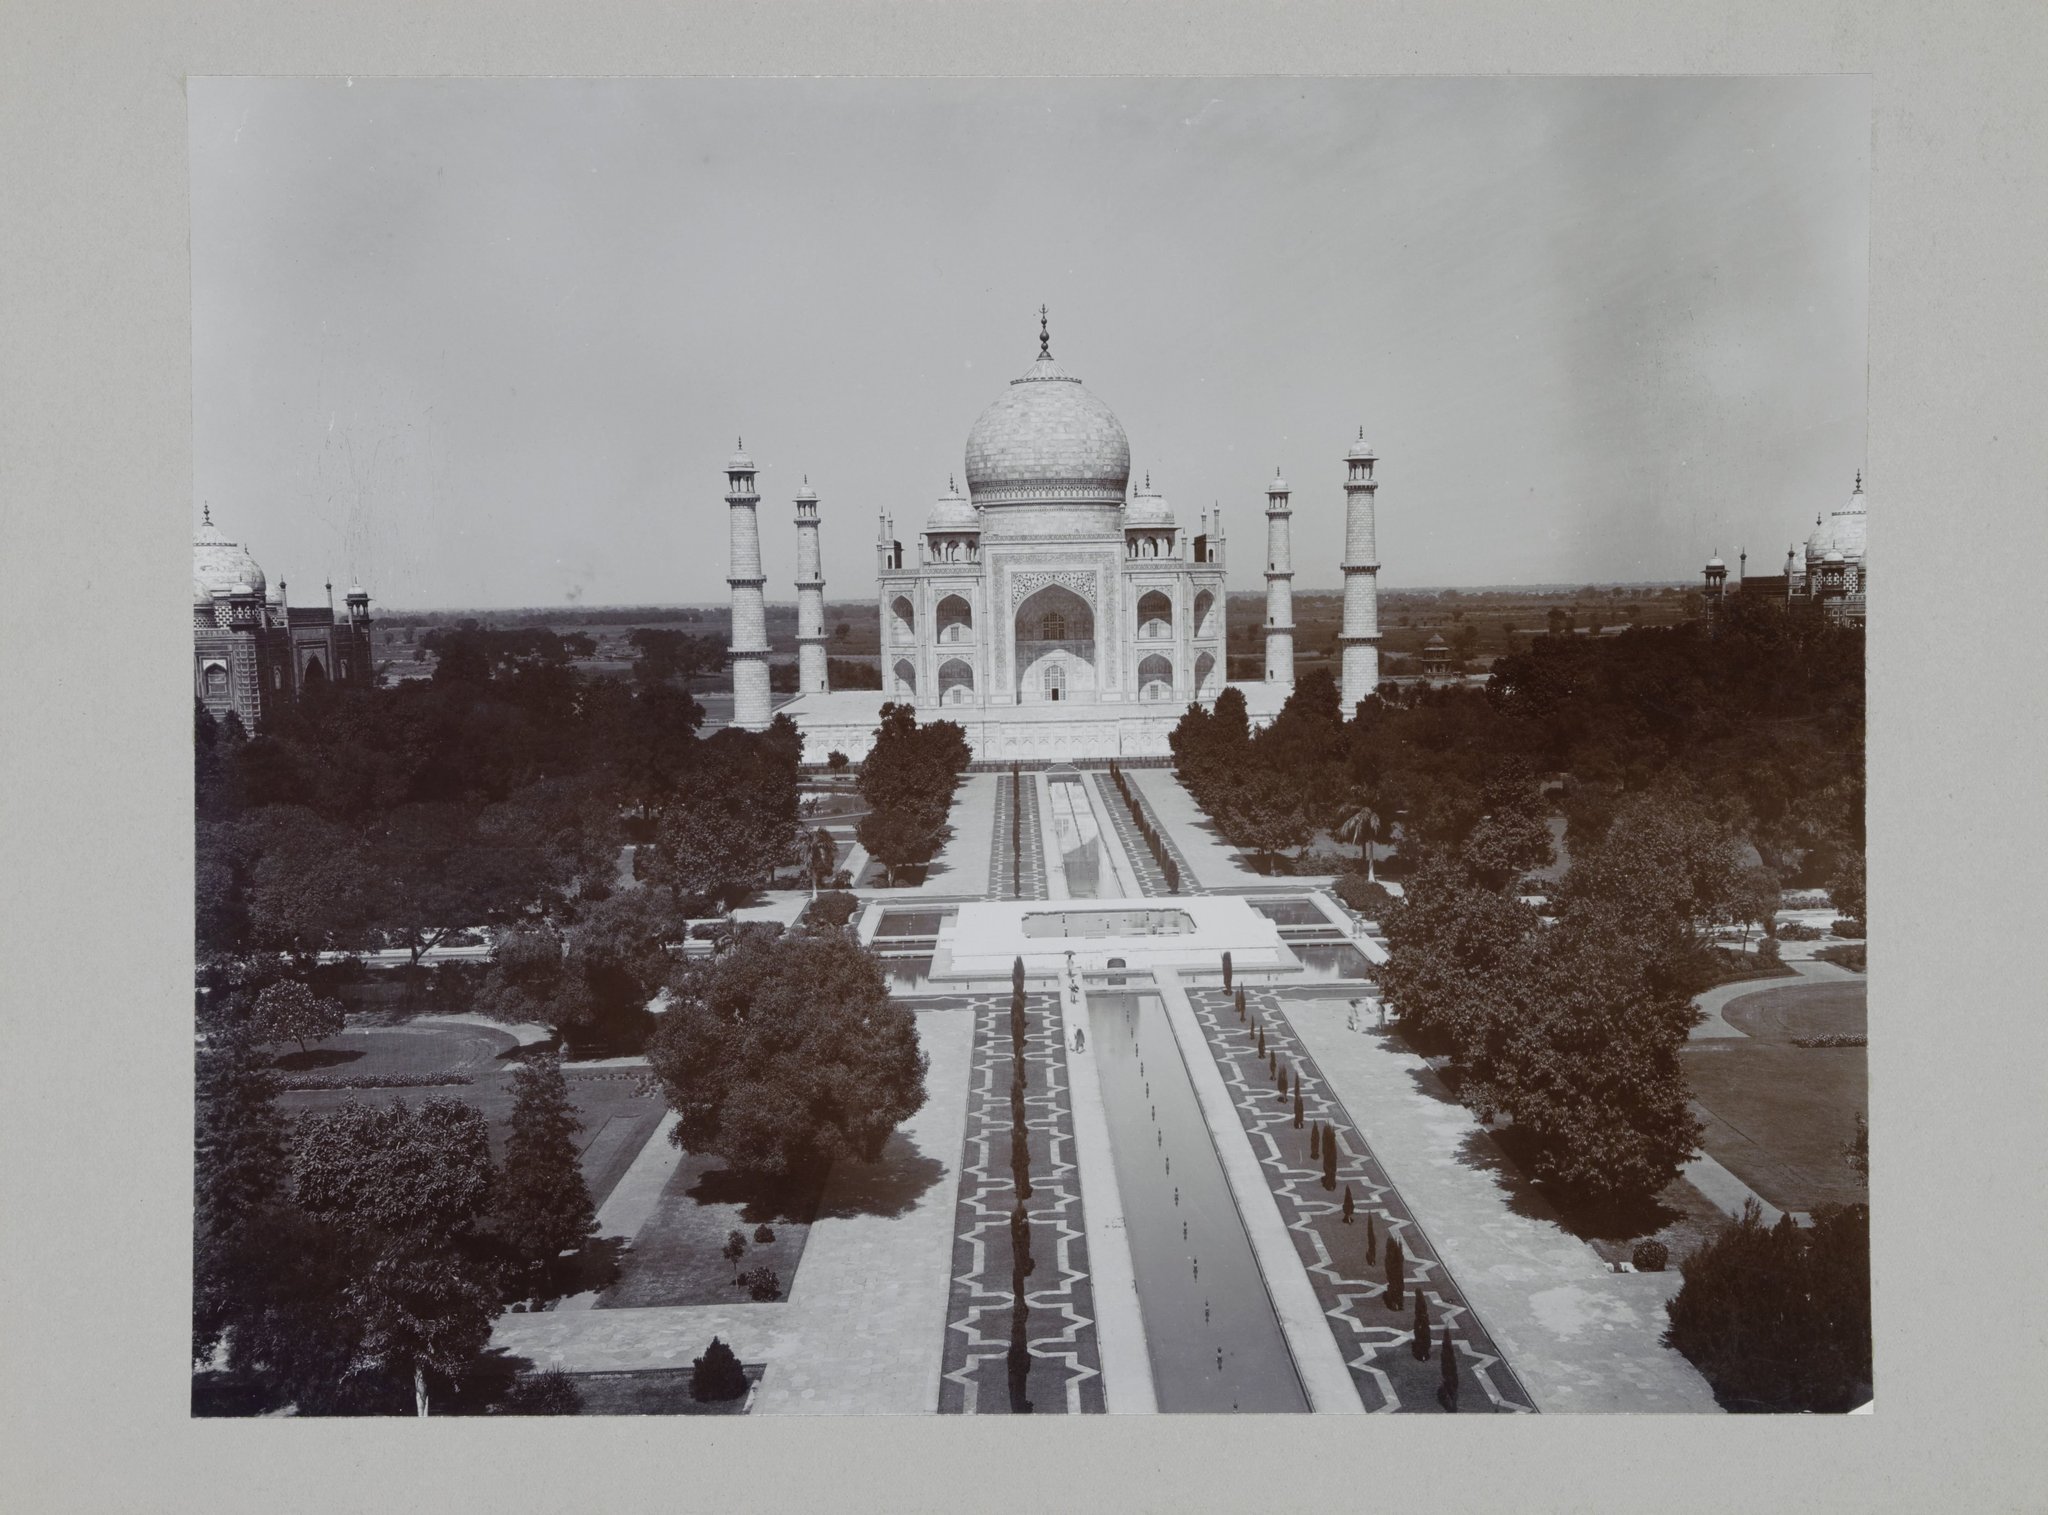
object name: photograph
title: View of the Taj Mahal, Agra, Uttar Pradesh, India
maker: Anonymous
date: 1895-1915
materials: cardboard, paper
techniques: gelatin silver print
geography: agra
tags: agra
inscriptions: annotation: ‘54. Tadj. Mahal’